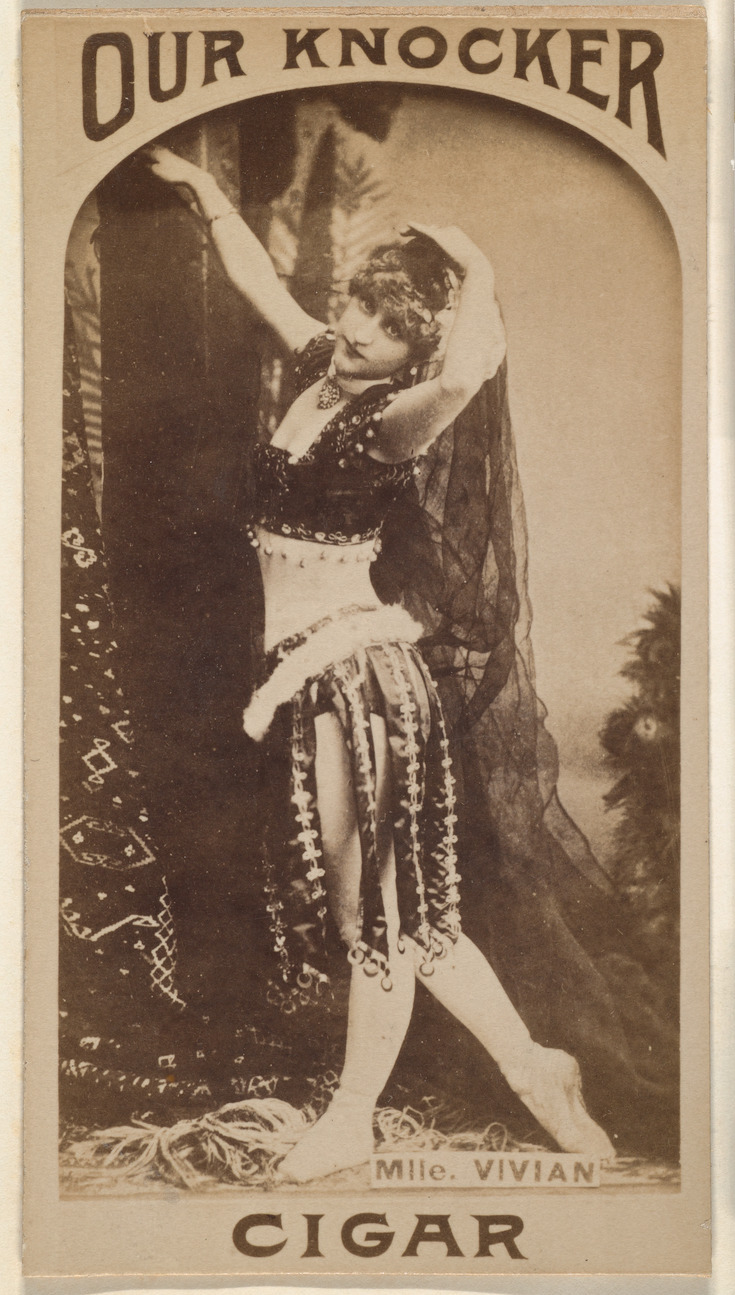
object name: photograph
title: Mlle. Vivian, from the Actresses series (N665) promoting Our Knocker Cigars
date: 1888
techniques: albumen silver print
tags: portraits,women,actresses